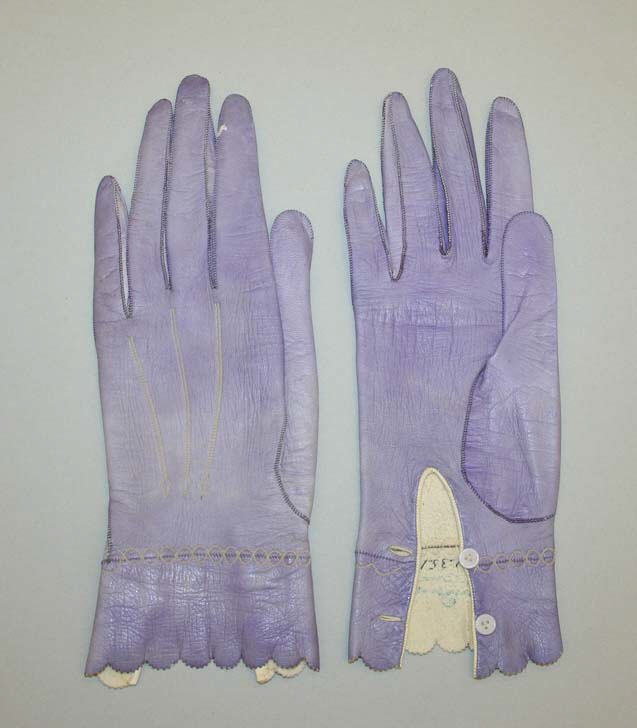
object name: glove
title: Gloves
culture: french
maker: alexandrine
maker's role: designer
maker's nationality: french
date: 1867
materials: leather